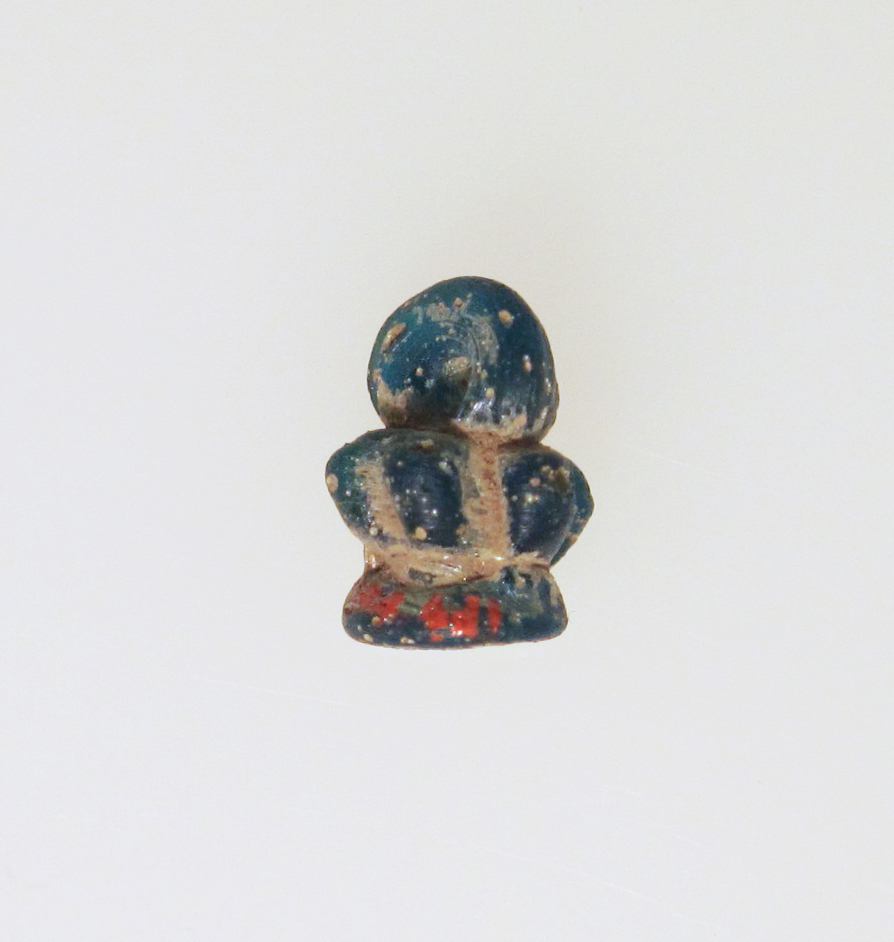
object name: pendant in the form of a jar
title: Glass pendant in the form of a jar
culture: roman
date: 201-400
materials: glass